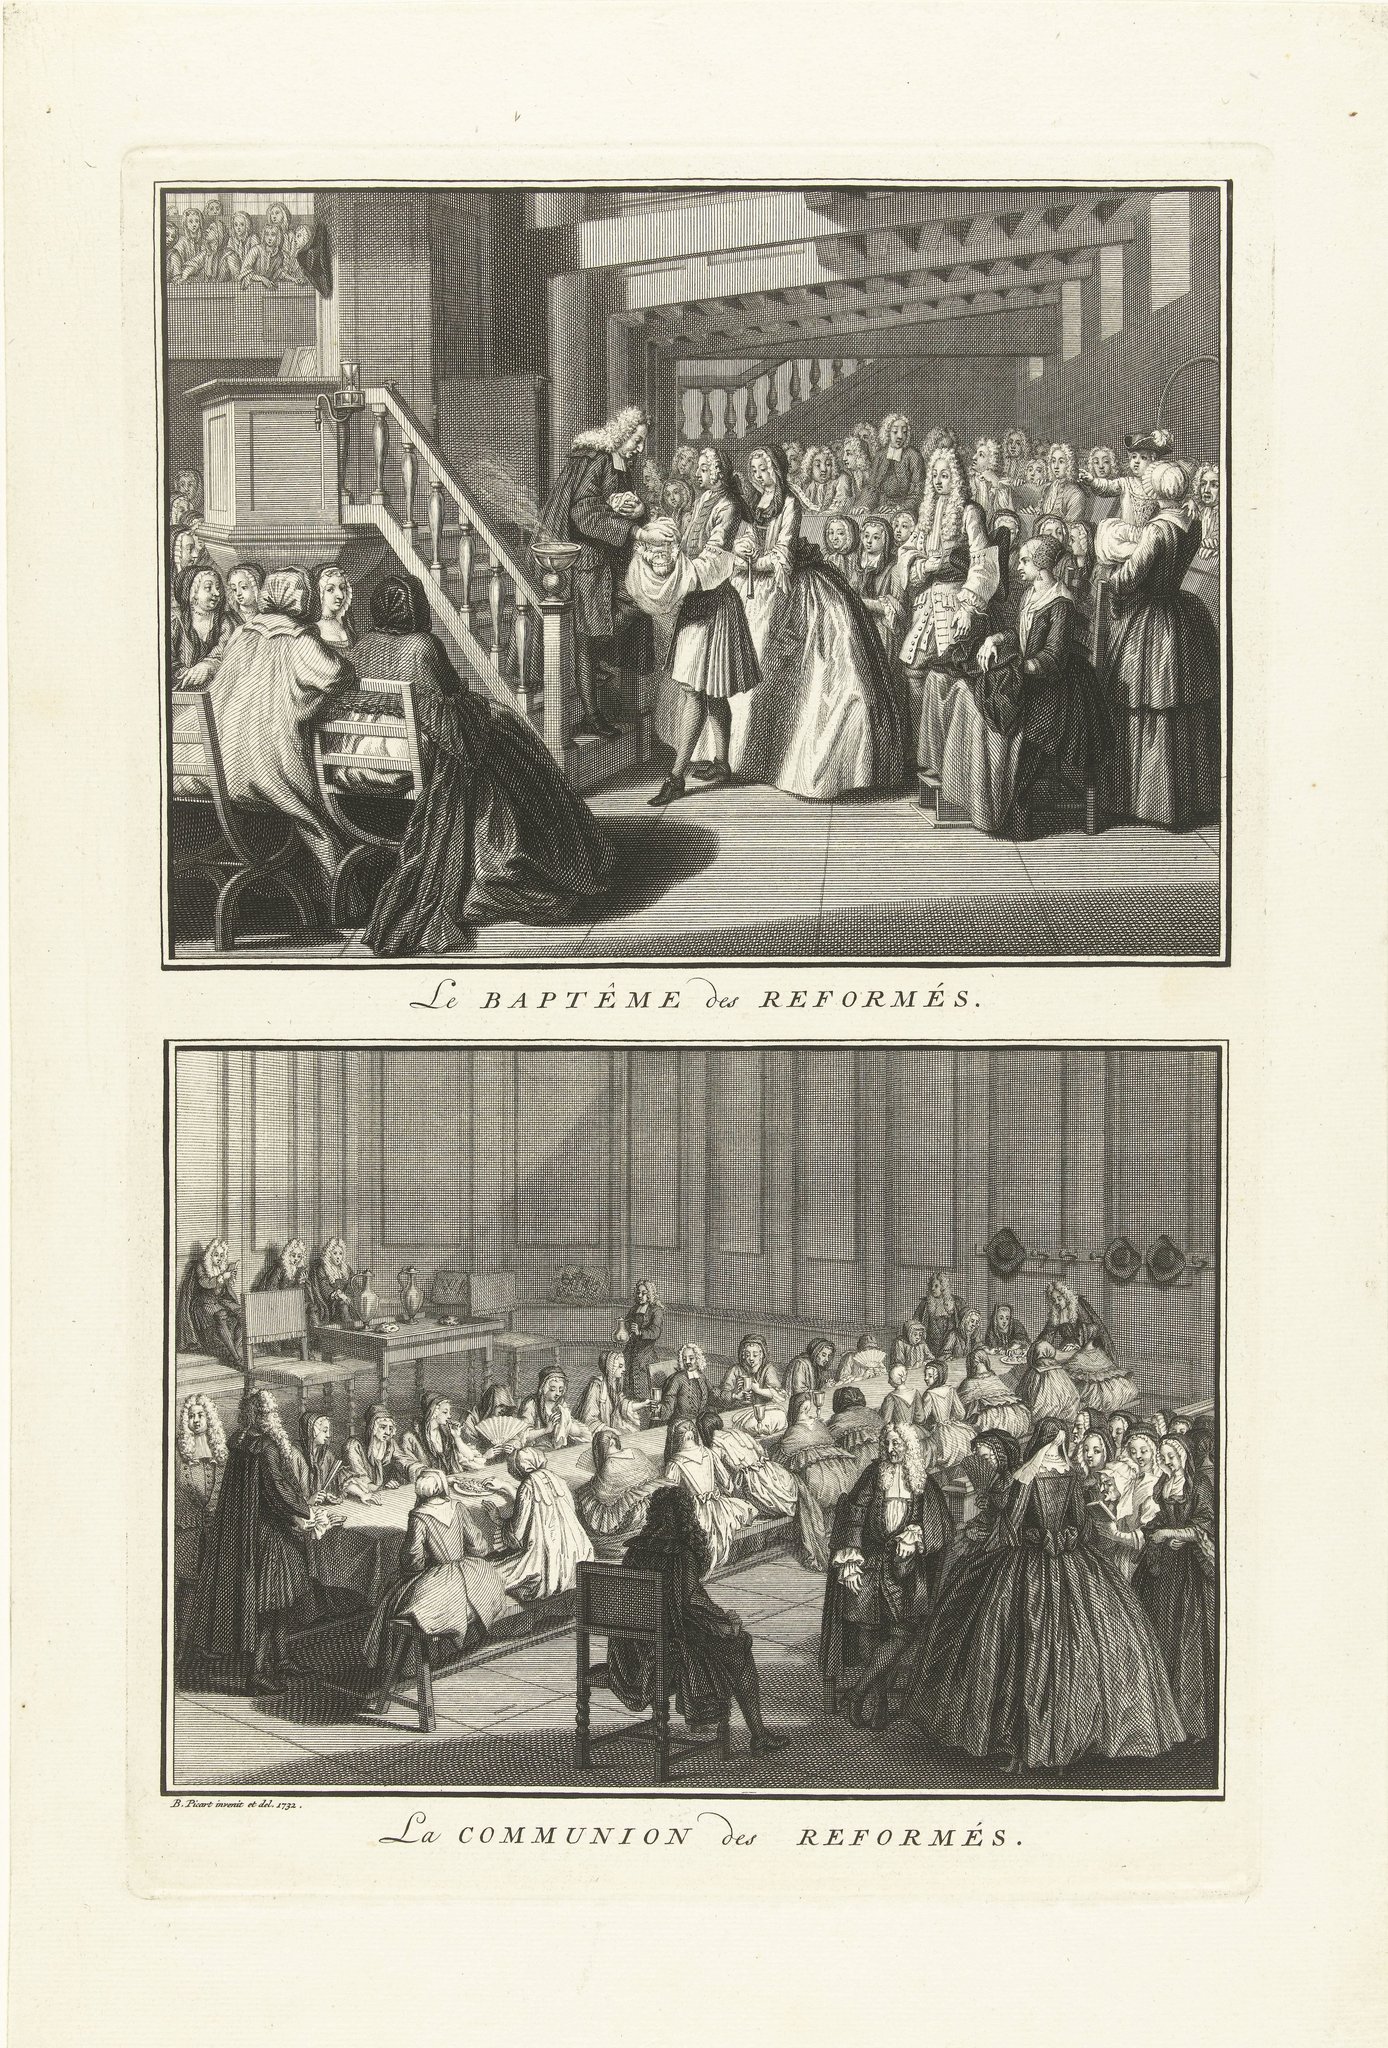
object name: print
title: Le Baptême des Reformés / La Communion des Reformés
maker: bernard picart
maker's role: draughtsman, print maker, publisher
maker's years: 1673-1733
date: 1732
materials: paper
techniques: engraving, etching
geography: northern netherlands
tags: holy communion ~ protestant service, baptism ~ protestant service, amsterdam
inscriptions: collector's mark: Lugt 2228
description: Gebruikt als illustratie in: A. Moubach. Naaukeurige beschryving der uitwendige godtsdienst-plichten, kerk-zeden en gewoontens van alle volkeren der waereldt.